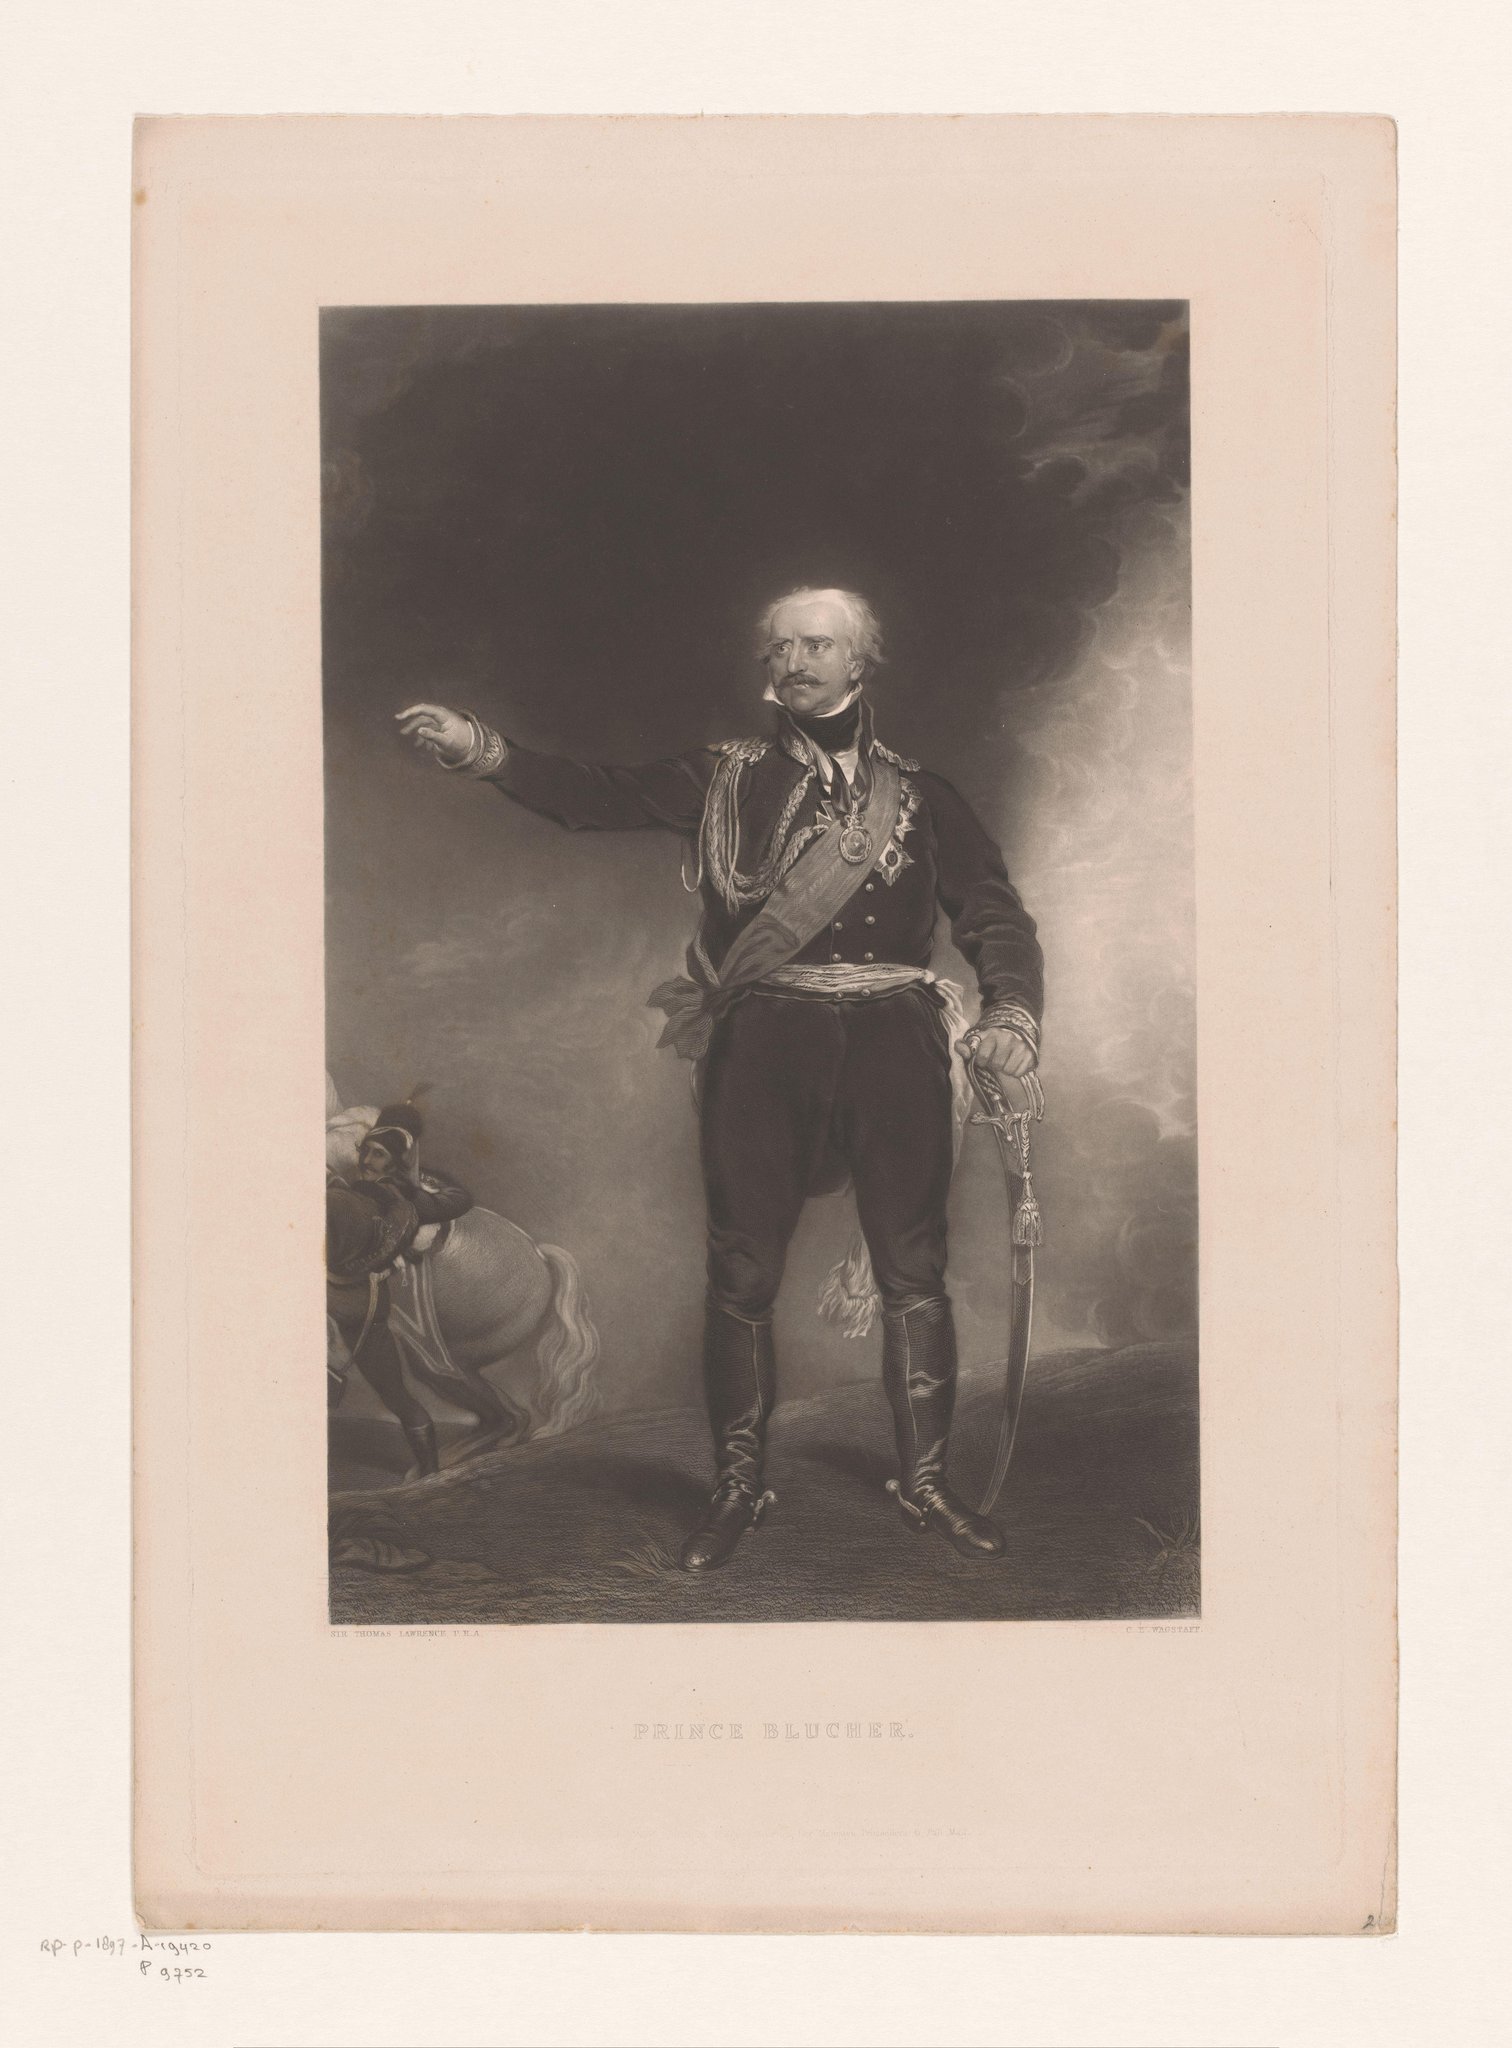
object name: print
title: Portret van Gebhard Leberecht von Blücher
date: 1839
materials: paper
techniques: etching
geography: london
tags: commander-in-chief, general, marshal, historical persons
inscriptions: collector's mark: Lugt 2228